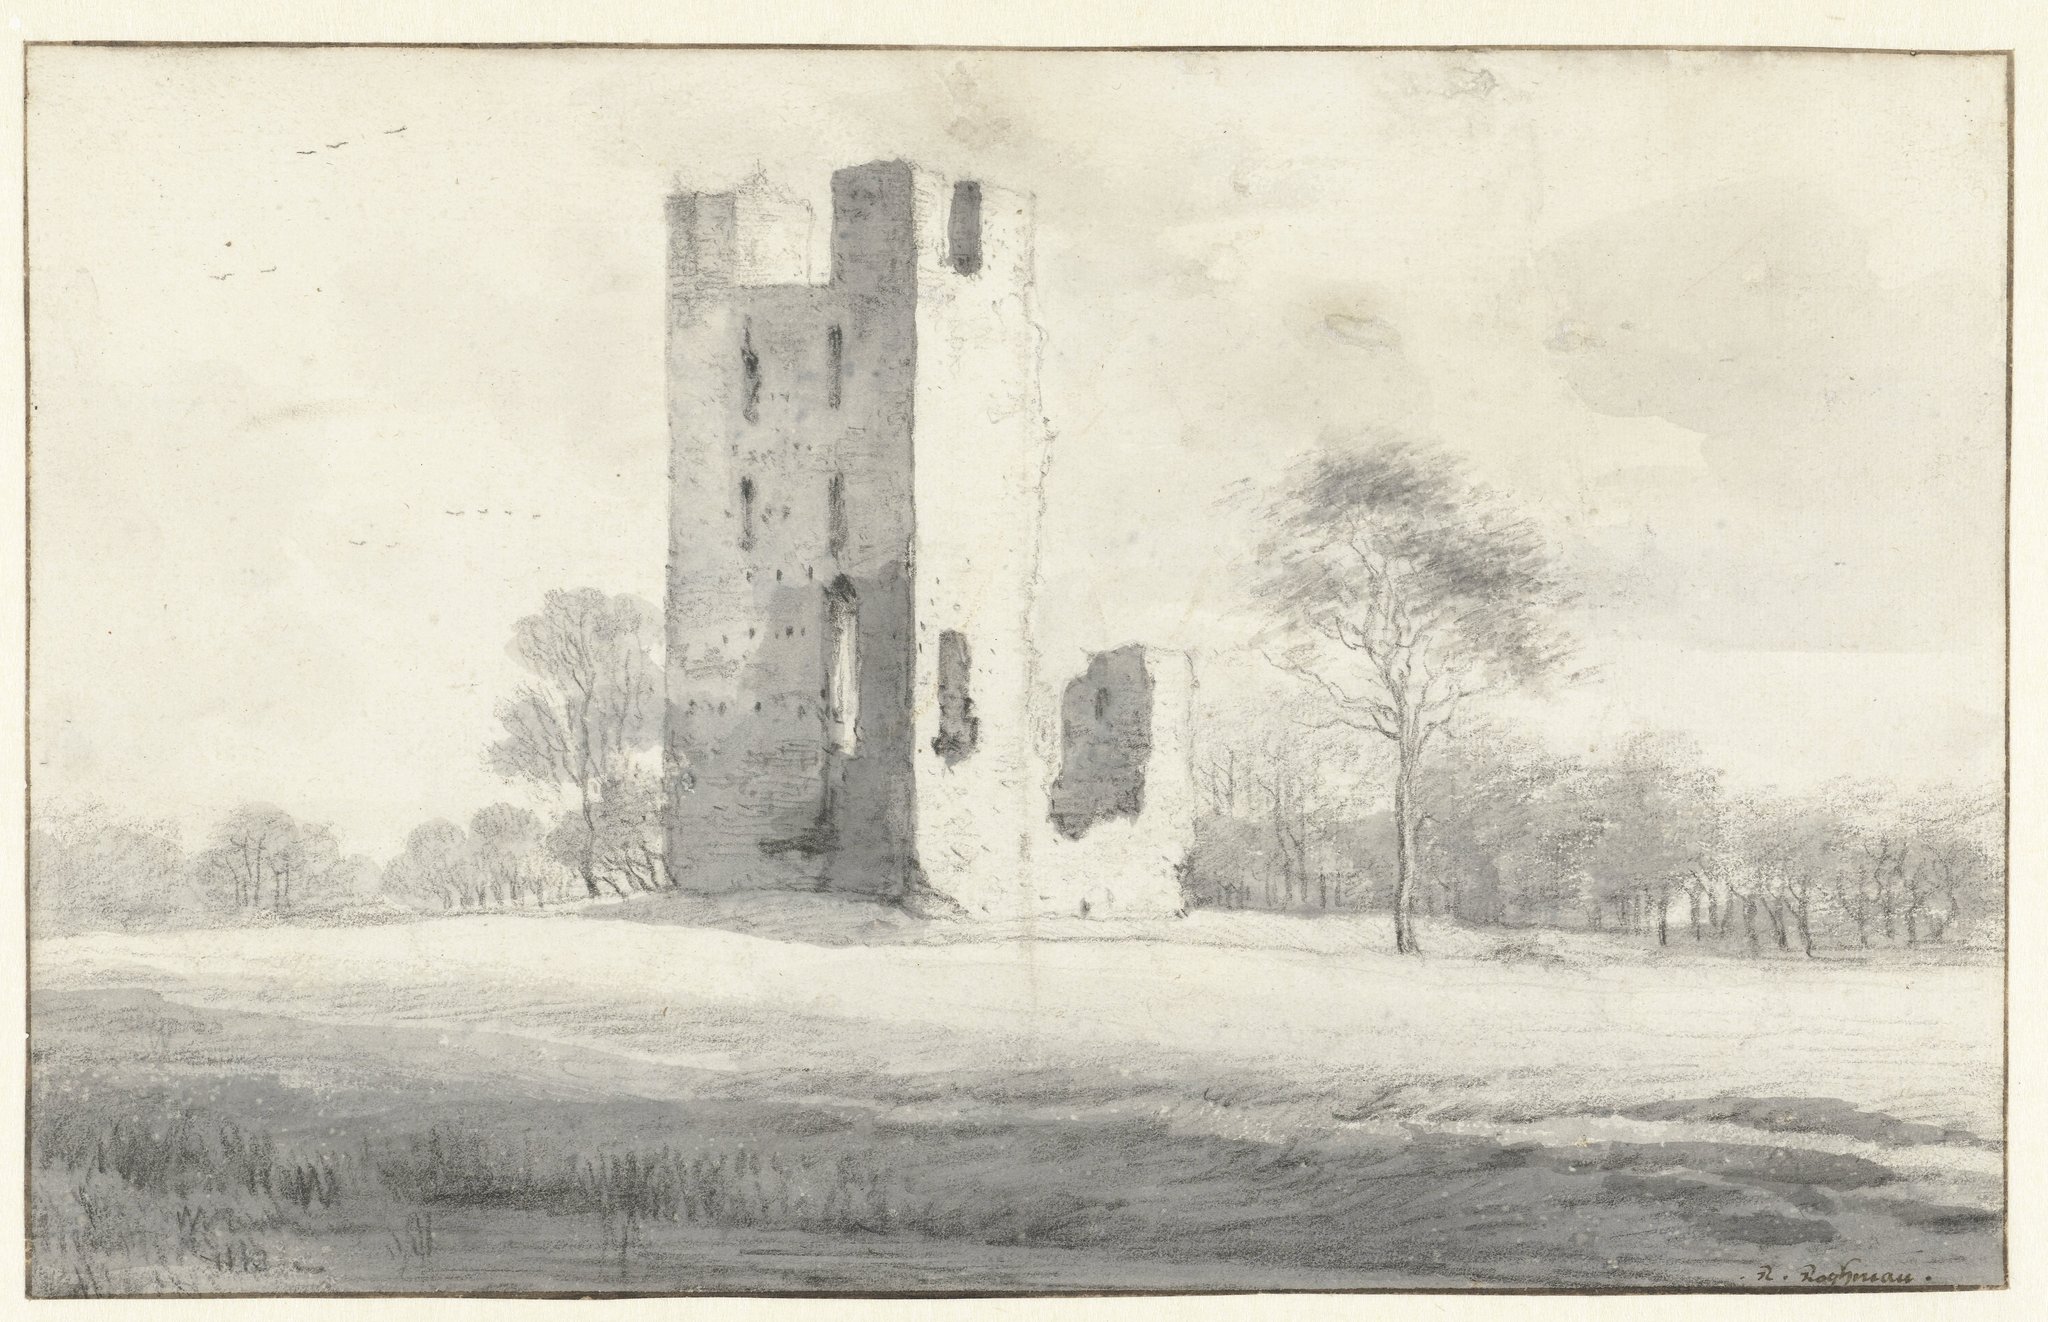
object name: drawing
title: View of Huis te Vliet, Seen from the South-west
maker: roelant roghman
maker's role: draughtsman, painter, print maker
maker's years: 1627-1692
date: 1646-1647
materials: chalk, ink, paper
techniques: brush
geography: huis te vliet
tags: castle, ruin of a building ~ architecture